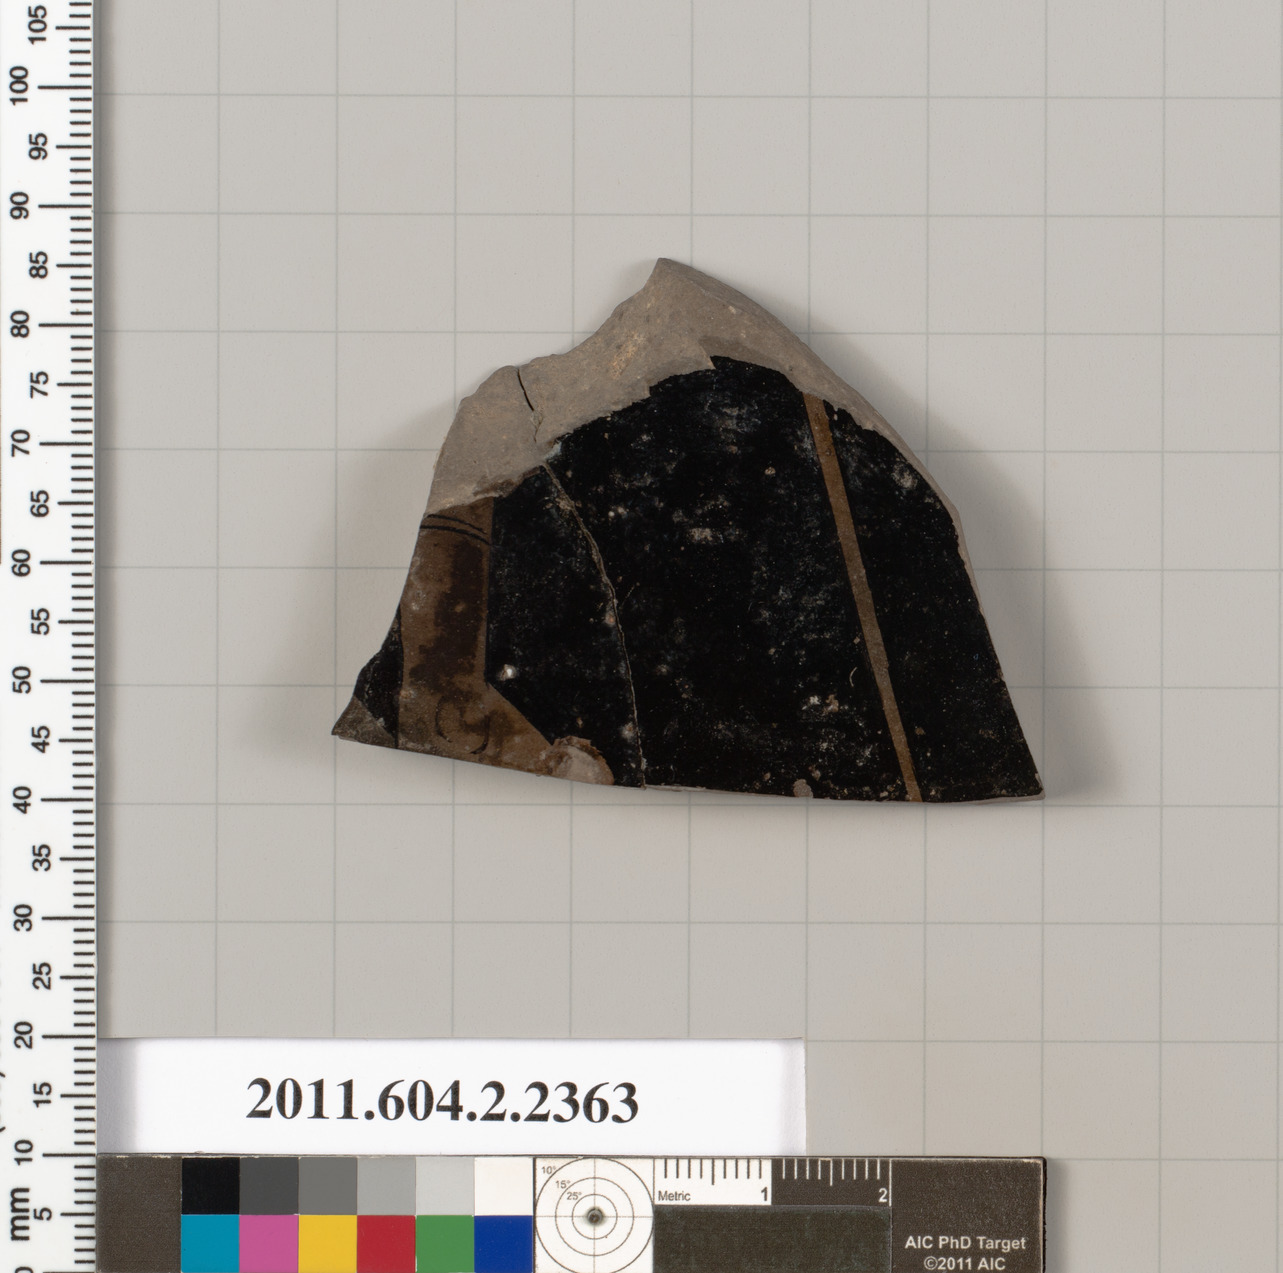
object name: pot fragment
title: Terracotta fragment of a pot; unglazed on the inside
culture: greek, attic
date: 467-435 BCE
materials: terracotta